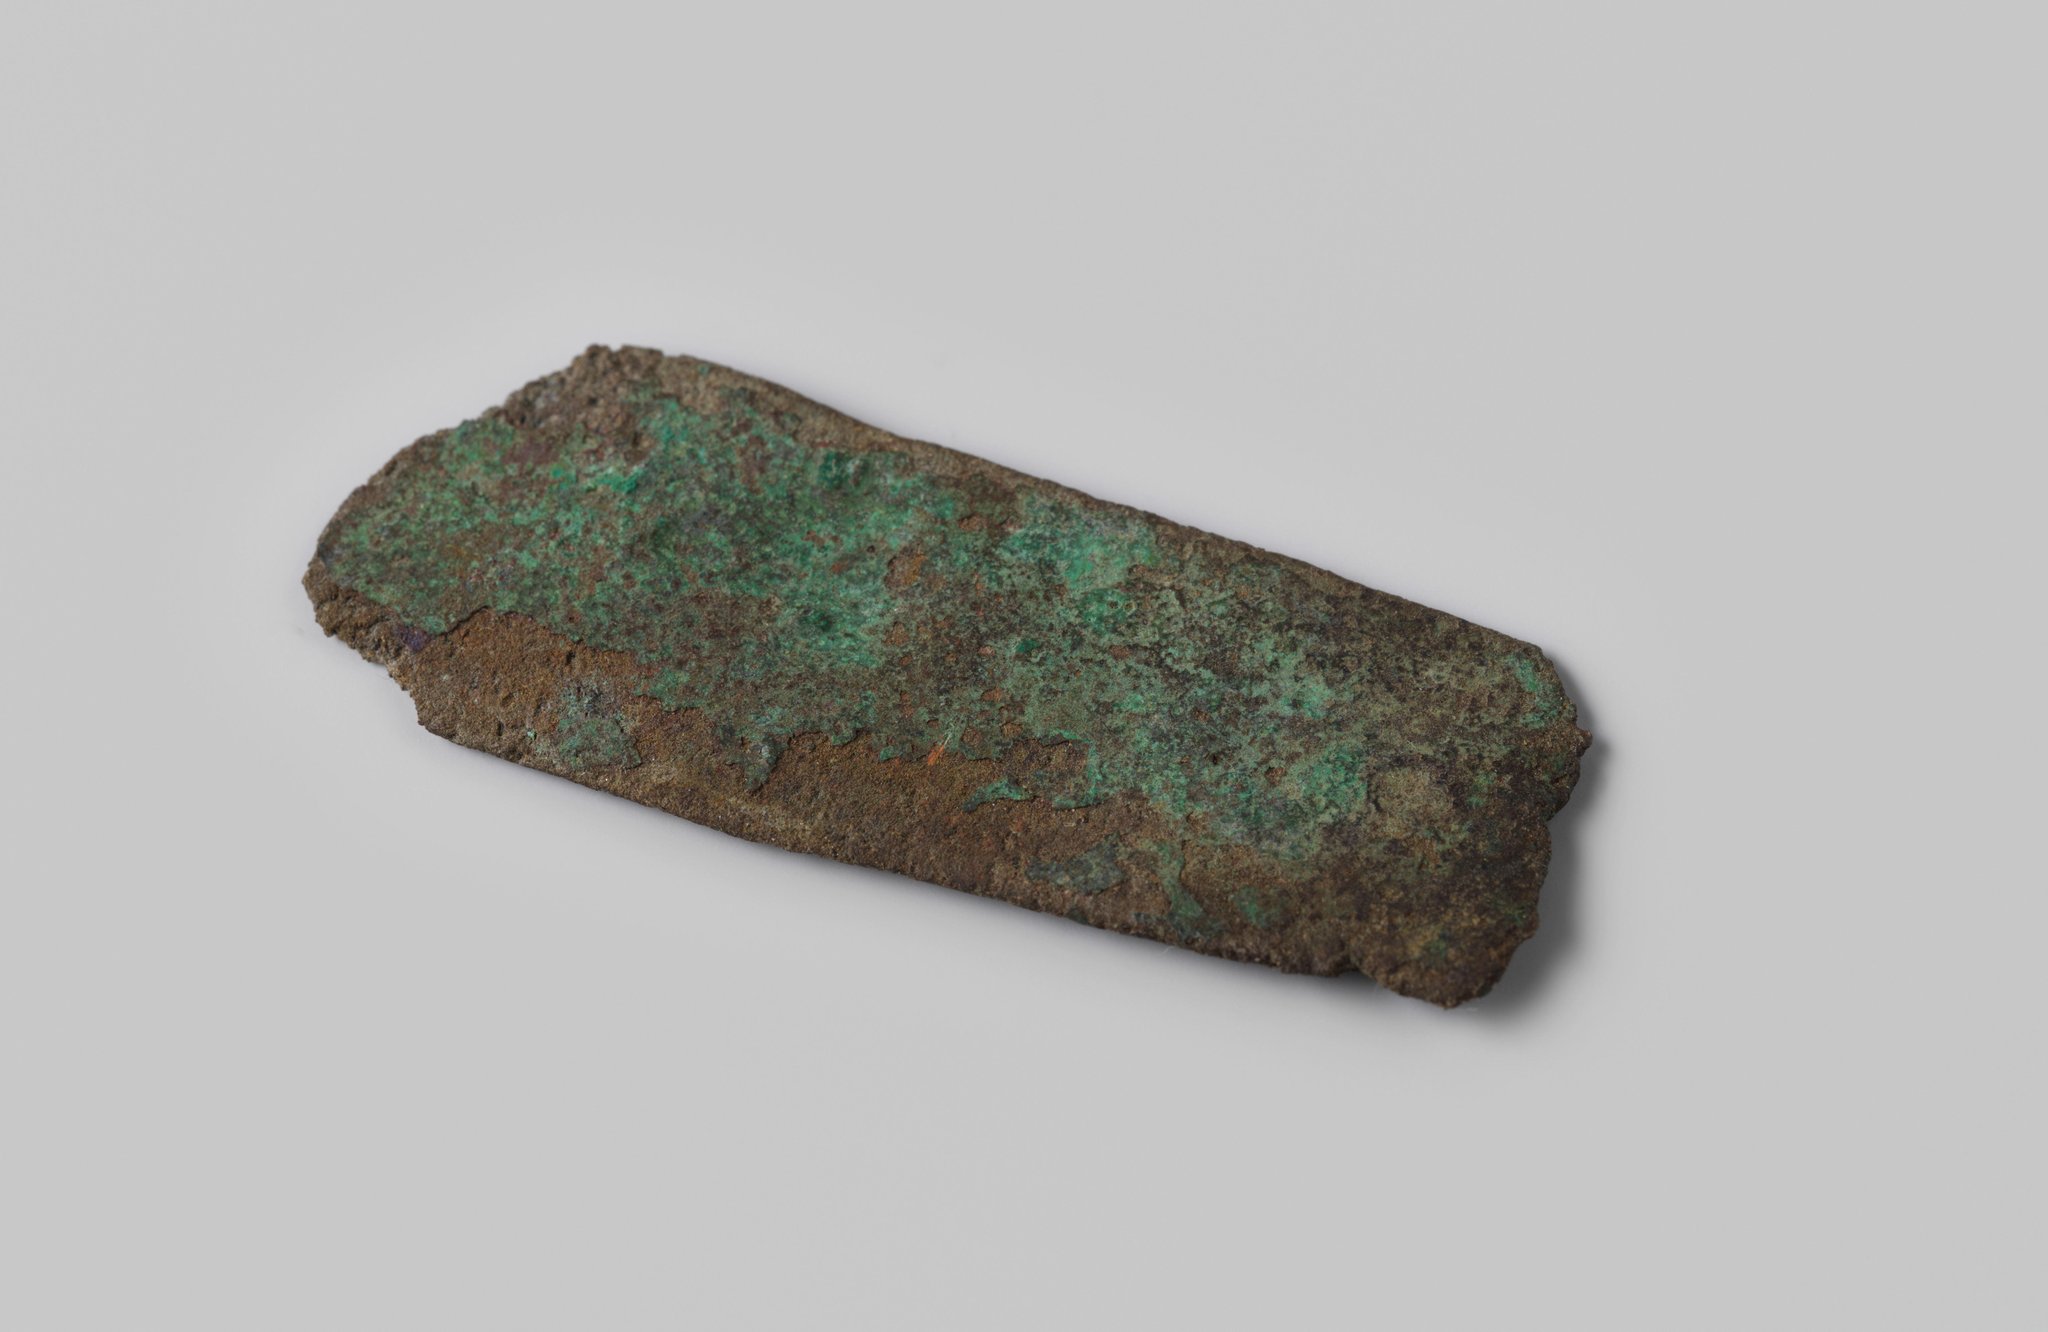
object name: fragment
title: Fragment van koper uit het wrak van de Oost-Indiëvaarder Hollandia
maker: Anonymous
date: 1700-1743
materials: copper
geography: netherlands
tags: verenigde oostindische compagnie, hollandia (schip), annet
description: Varied parts or fragments, strips and strip-shaped fragments; fragm.